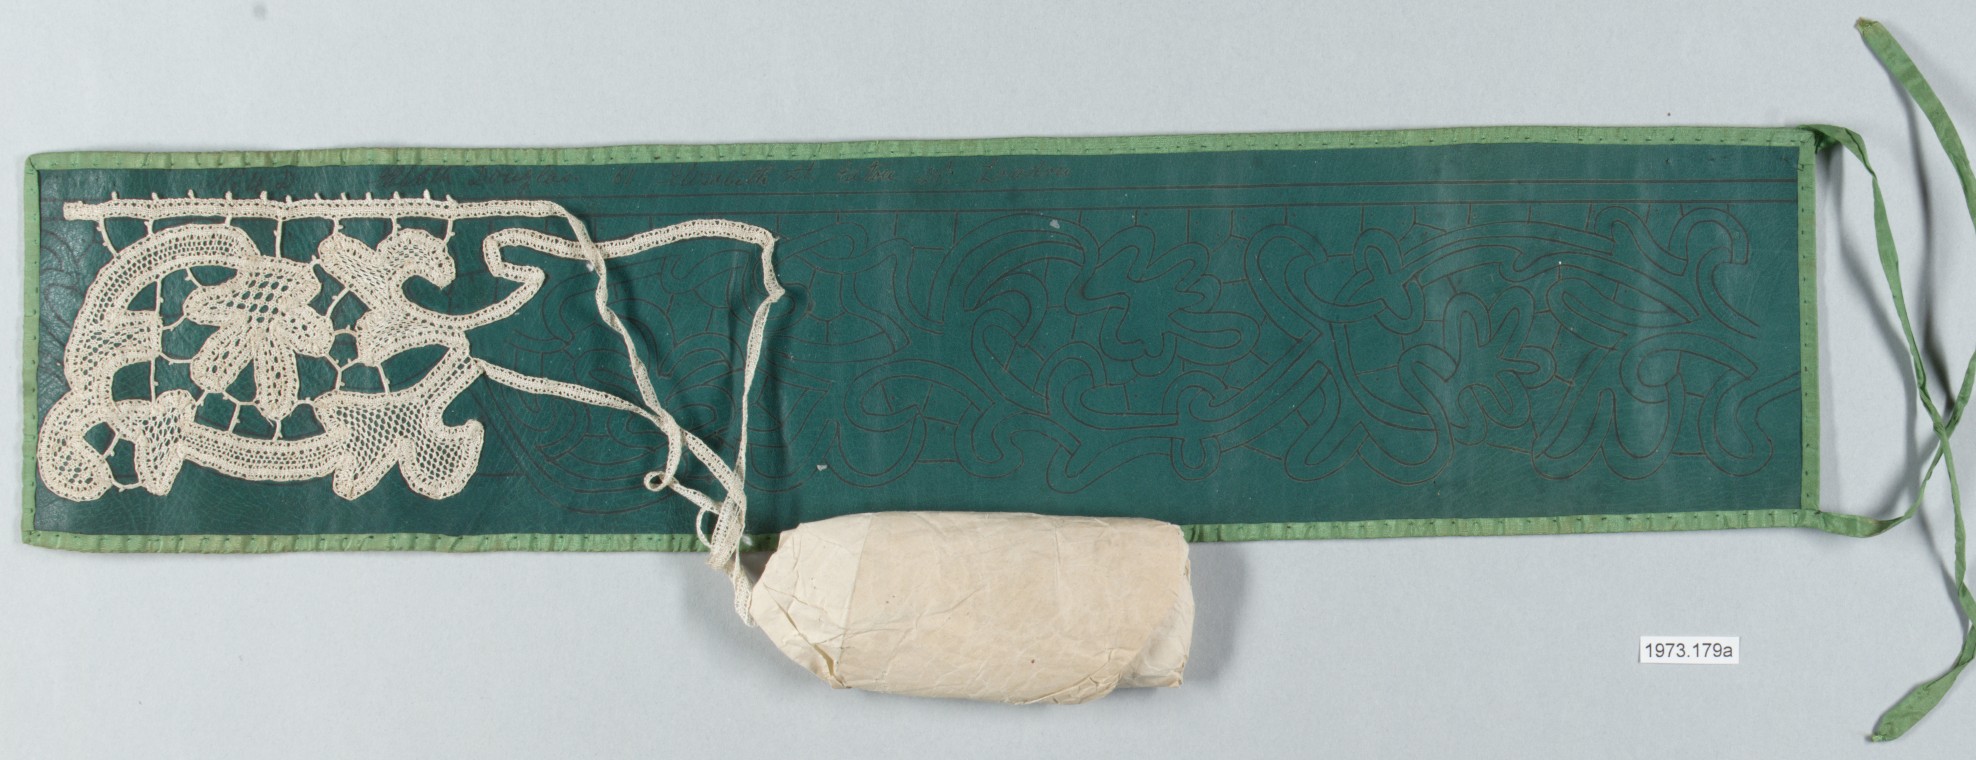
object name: strip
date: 1801-1900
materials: leather, linen, silk